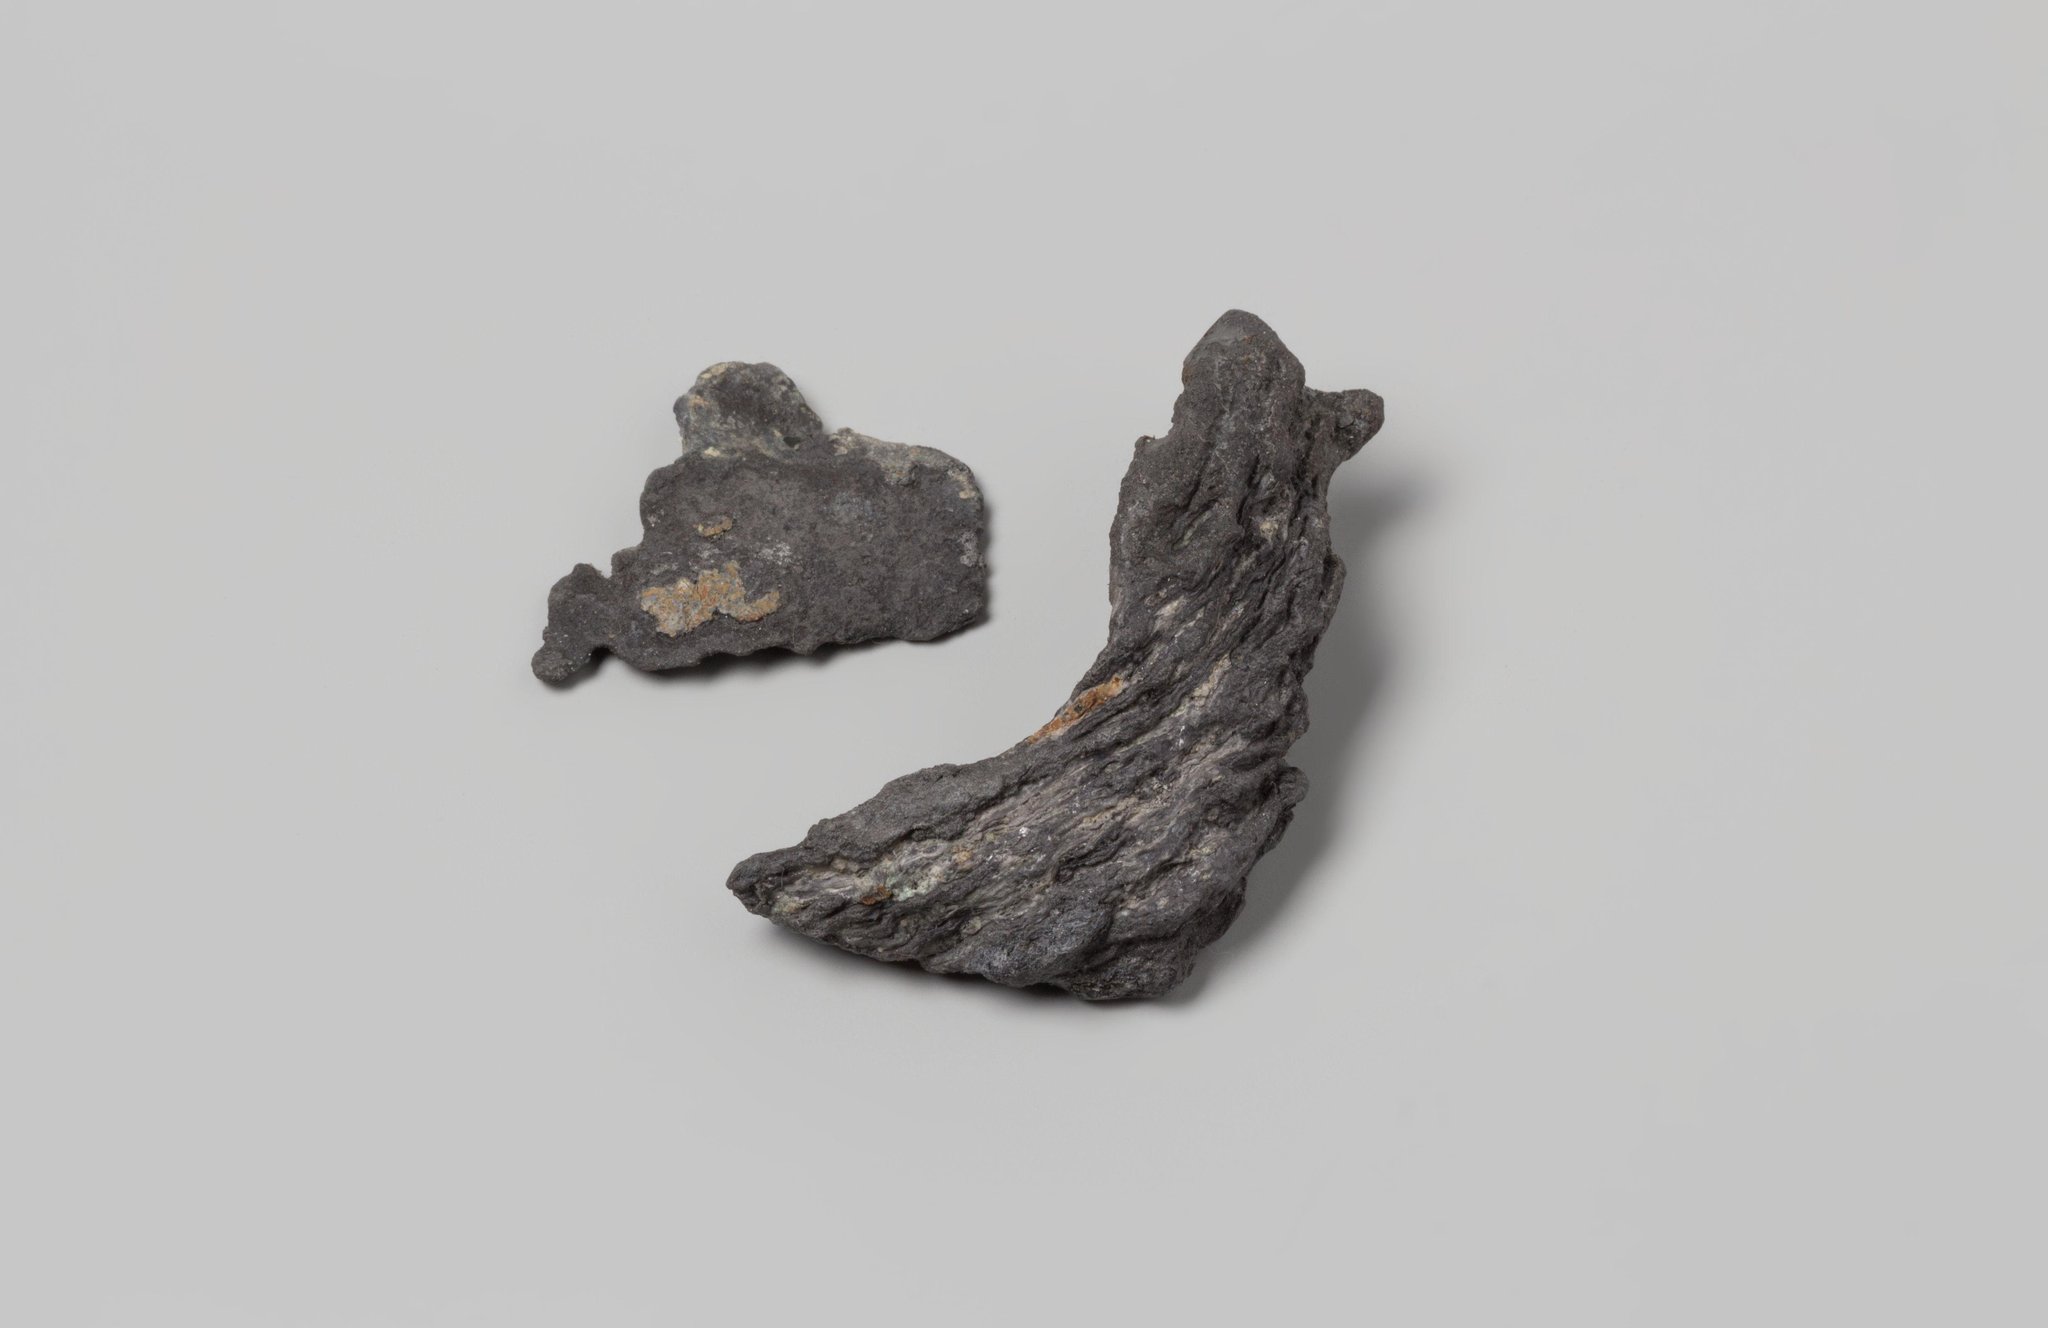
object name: fragment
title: Fragmenten lood uit het wrak van de Oost-Indiëvaarder Hollandia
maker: Anonymous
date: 1700-1743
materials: lead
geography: netherlands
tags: verenigde oostindische compagnie, hollandia (schip), annet